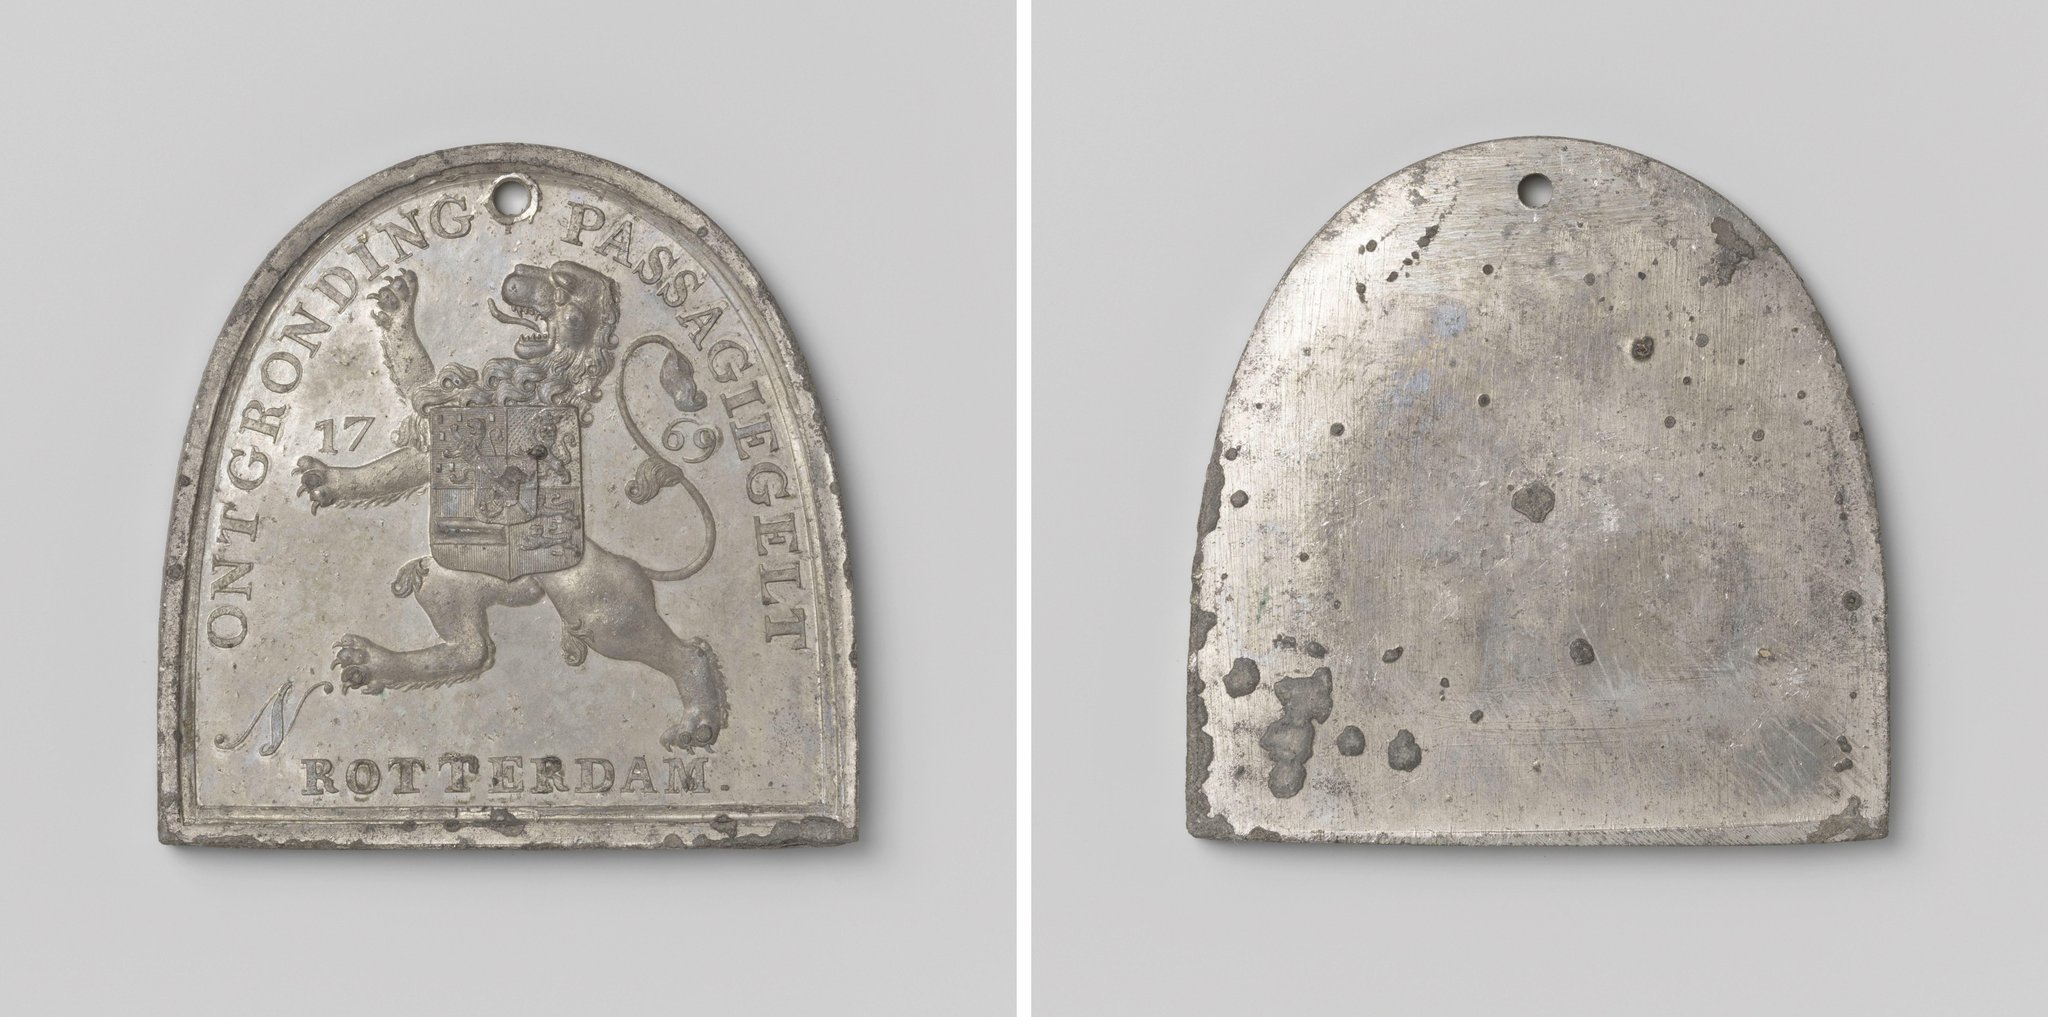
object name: identification medal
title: Ontgronding te Rotterdam, penning bedoeld als bewijs voor turfdragers, -vullers of -tonners om turf in te mogen voeren uit de nieuw ontgronde venen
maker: Anonymous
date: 1769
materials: lead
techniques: casting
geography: rotterdam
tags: rotterdam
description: Eenzijdige loden penning met ronde boven- en rechthoekige onderzijde, en gat erin. Voorzijde: staande leeuw met wapenschild op borst tussen jaartal binnen omschrift. Keerzijde: blanco.